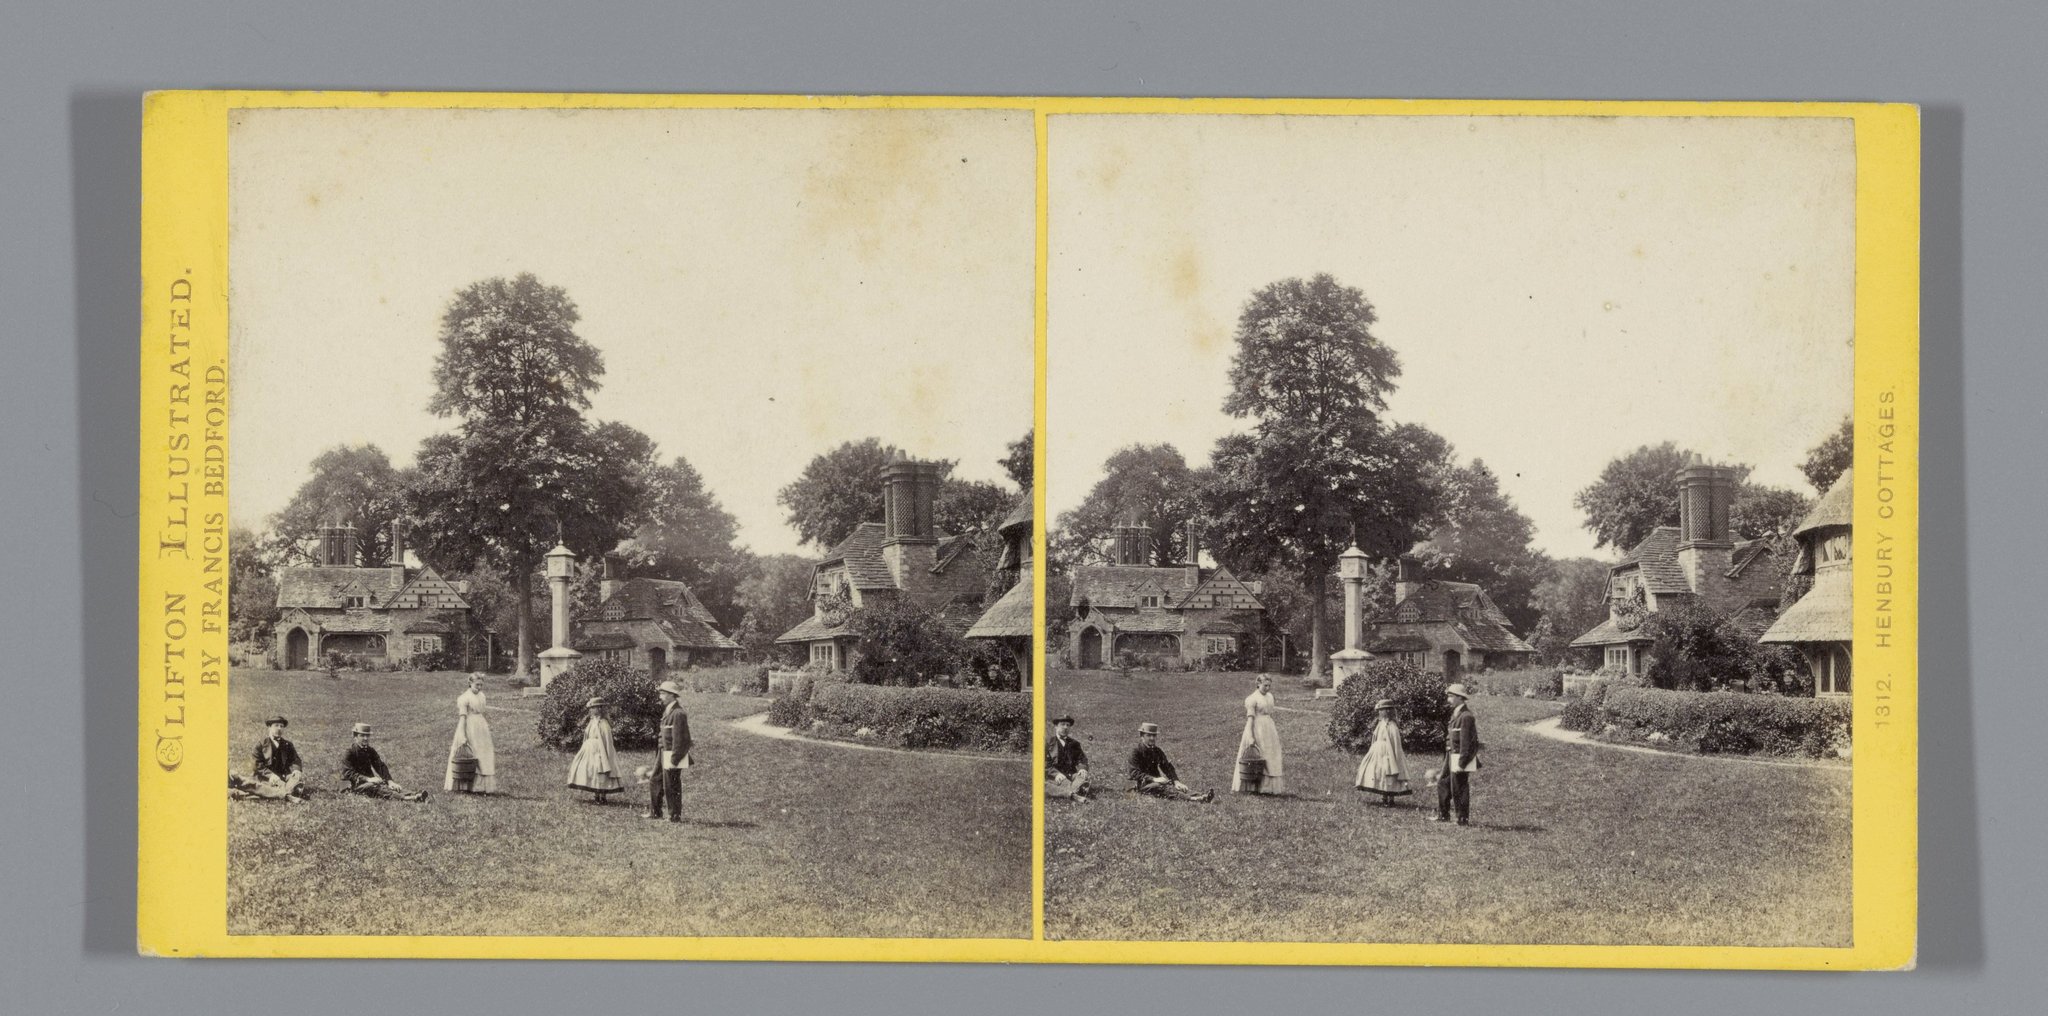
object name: stereograph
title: Gezicht op huizen te Henbury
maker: francis bedford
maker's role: print maker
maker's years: 1815-1894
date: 1850-1880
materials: cardboard, photographic support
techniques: albumen print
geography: henbury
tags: cottage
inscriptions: inscription: ‘Clifton Illustrated. by Francis Bedford.’, number: ‘1312.’